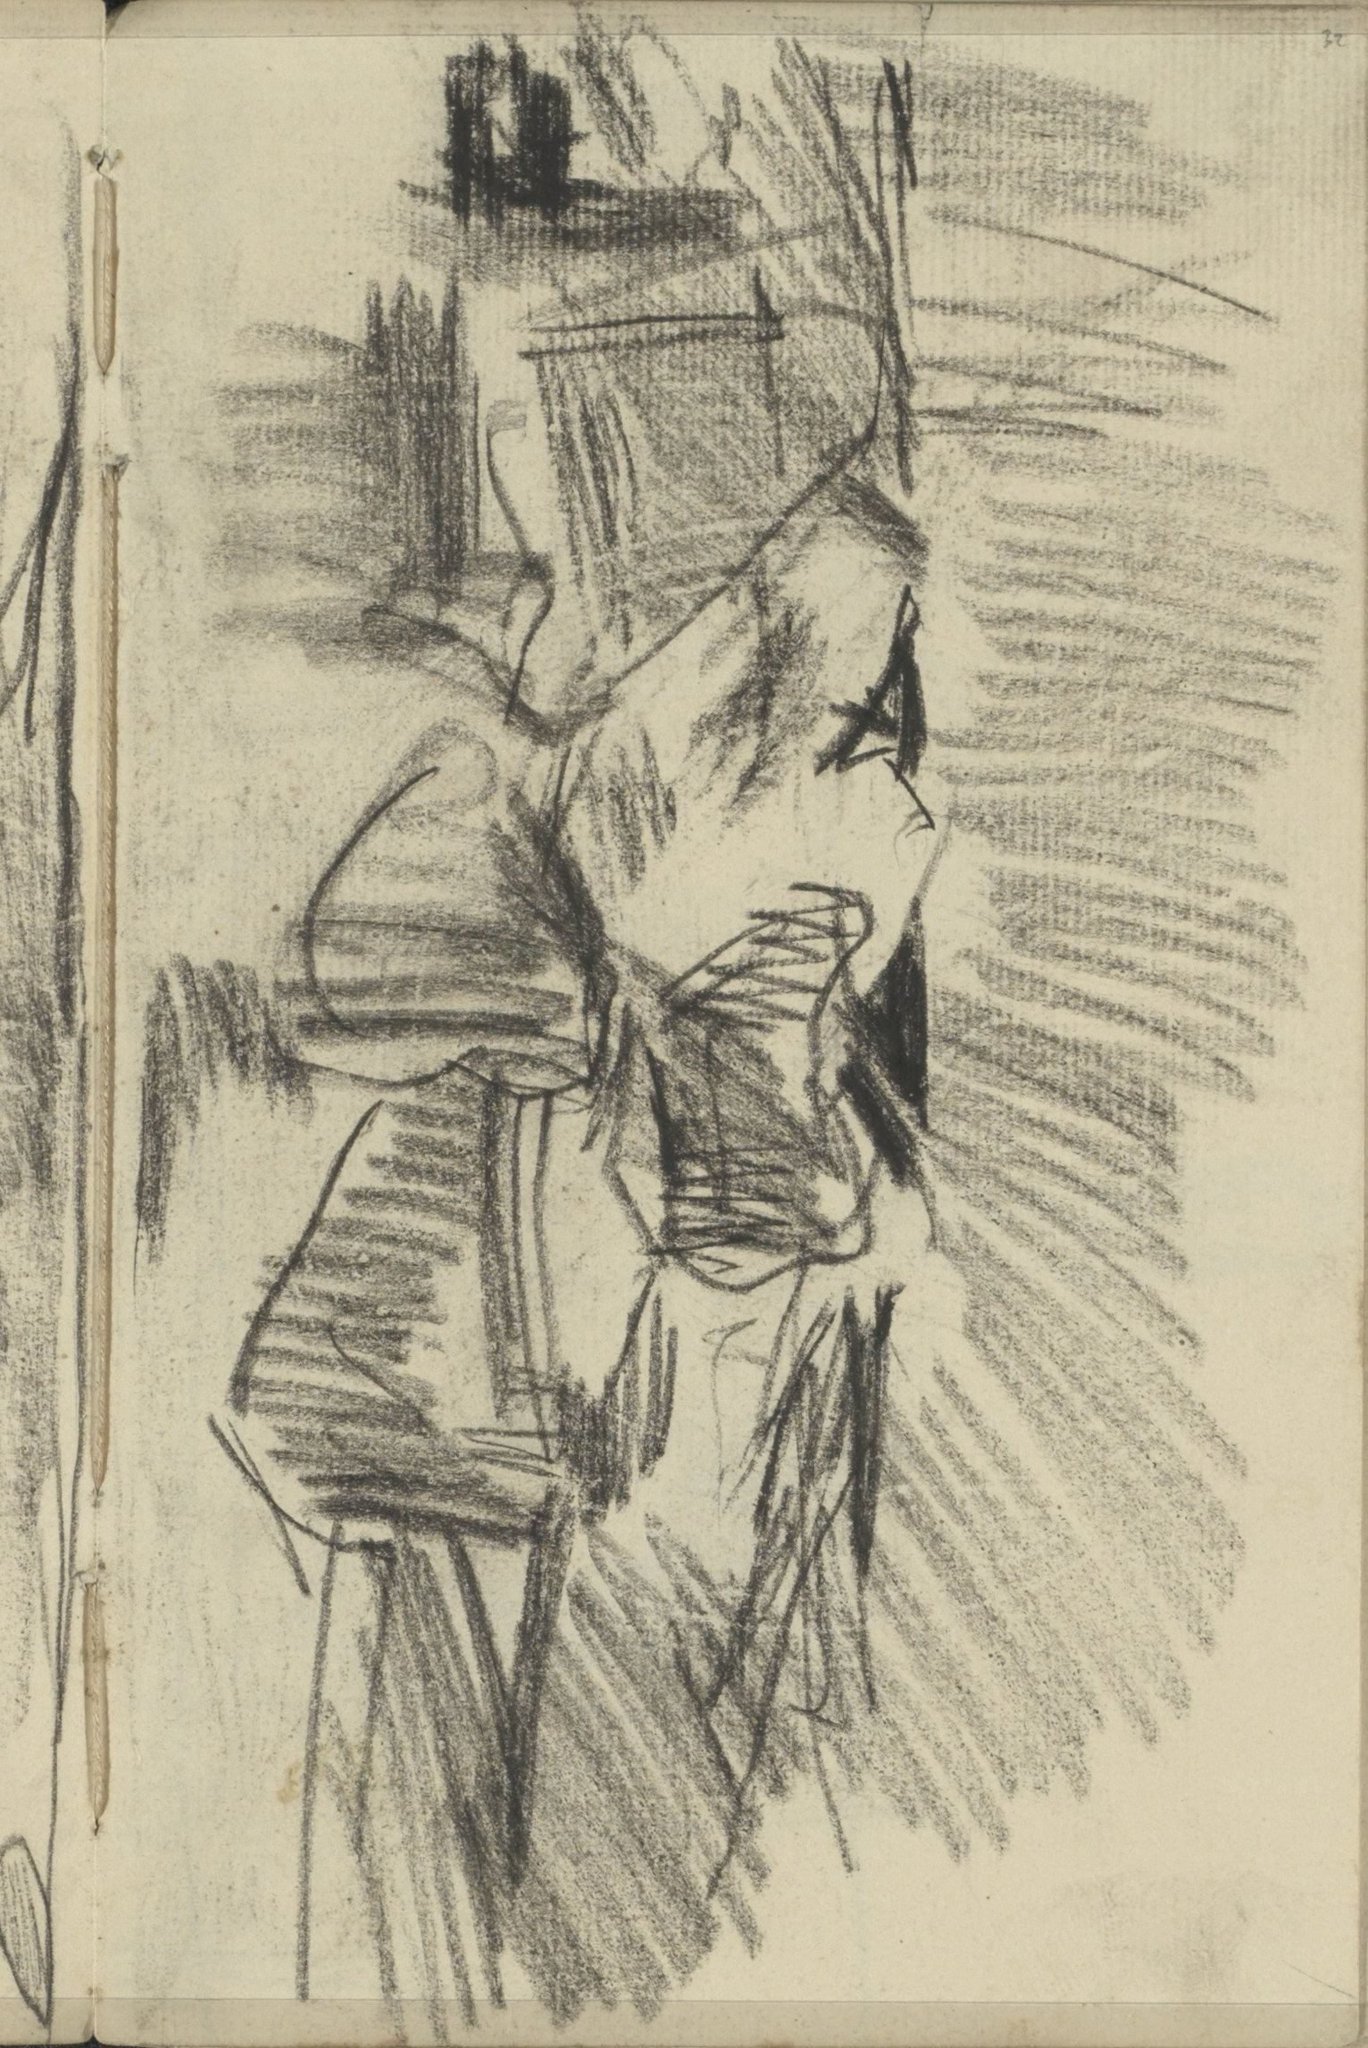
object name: sketchbook leaf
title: Landschap, mogelijk een duinlandschap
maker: george hendrik breitner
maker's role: draughtsman, painter, print maker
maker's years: 1857-1923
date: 1882-1884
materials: chalk, paper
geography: the hague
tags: dunes (sea not visible); in the dunes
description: Pagina 32 uit een schetsboek met 24 bladen.